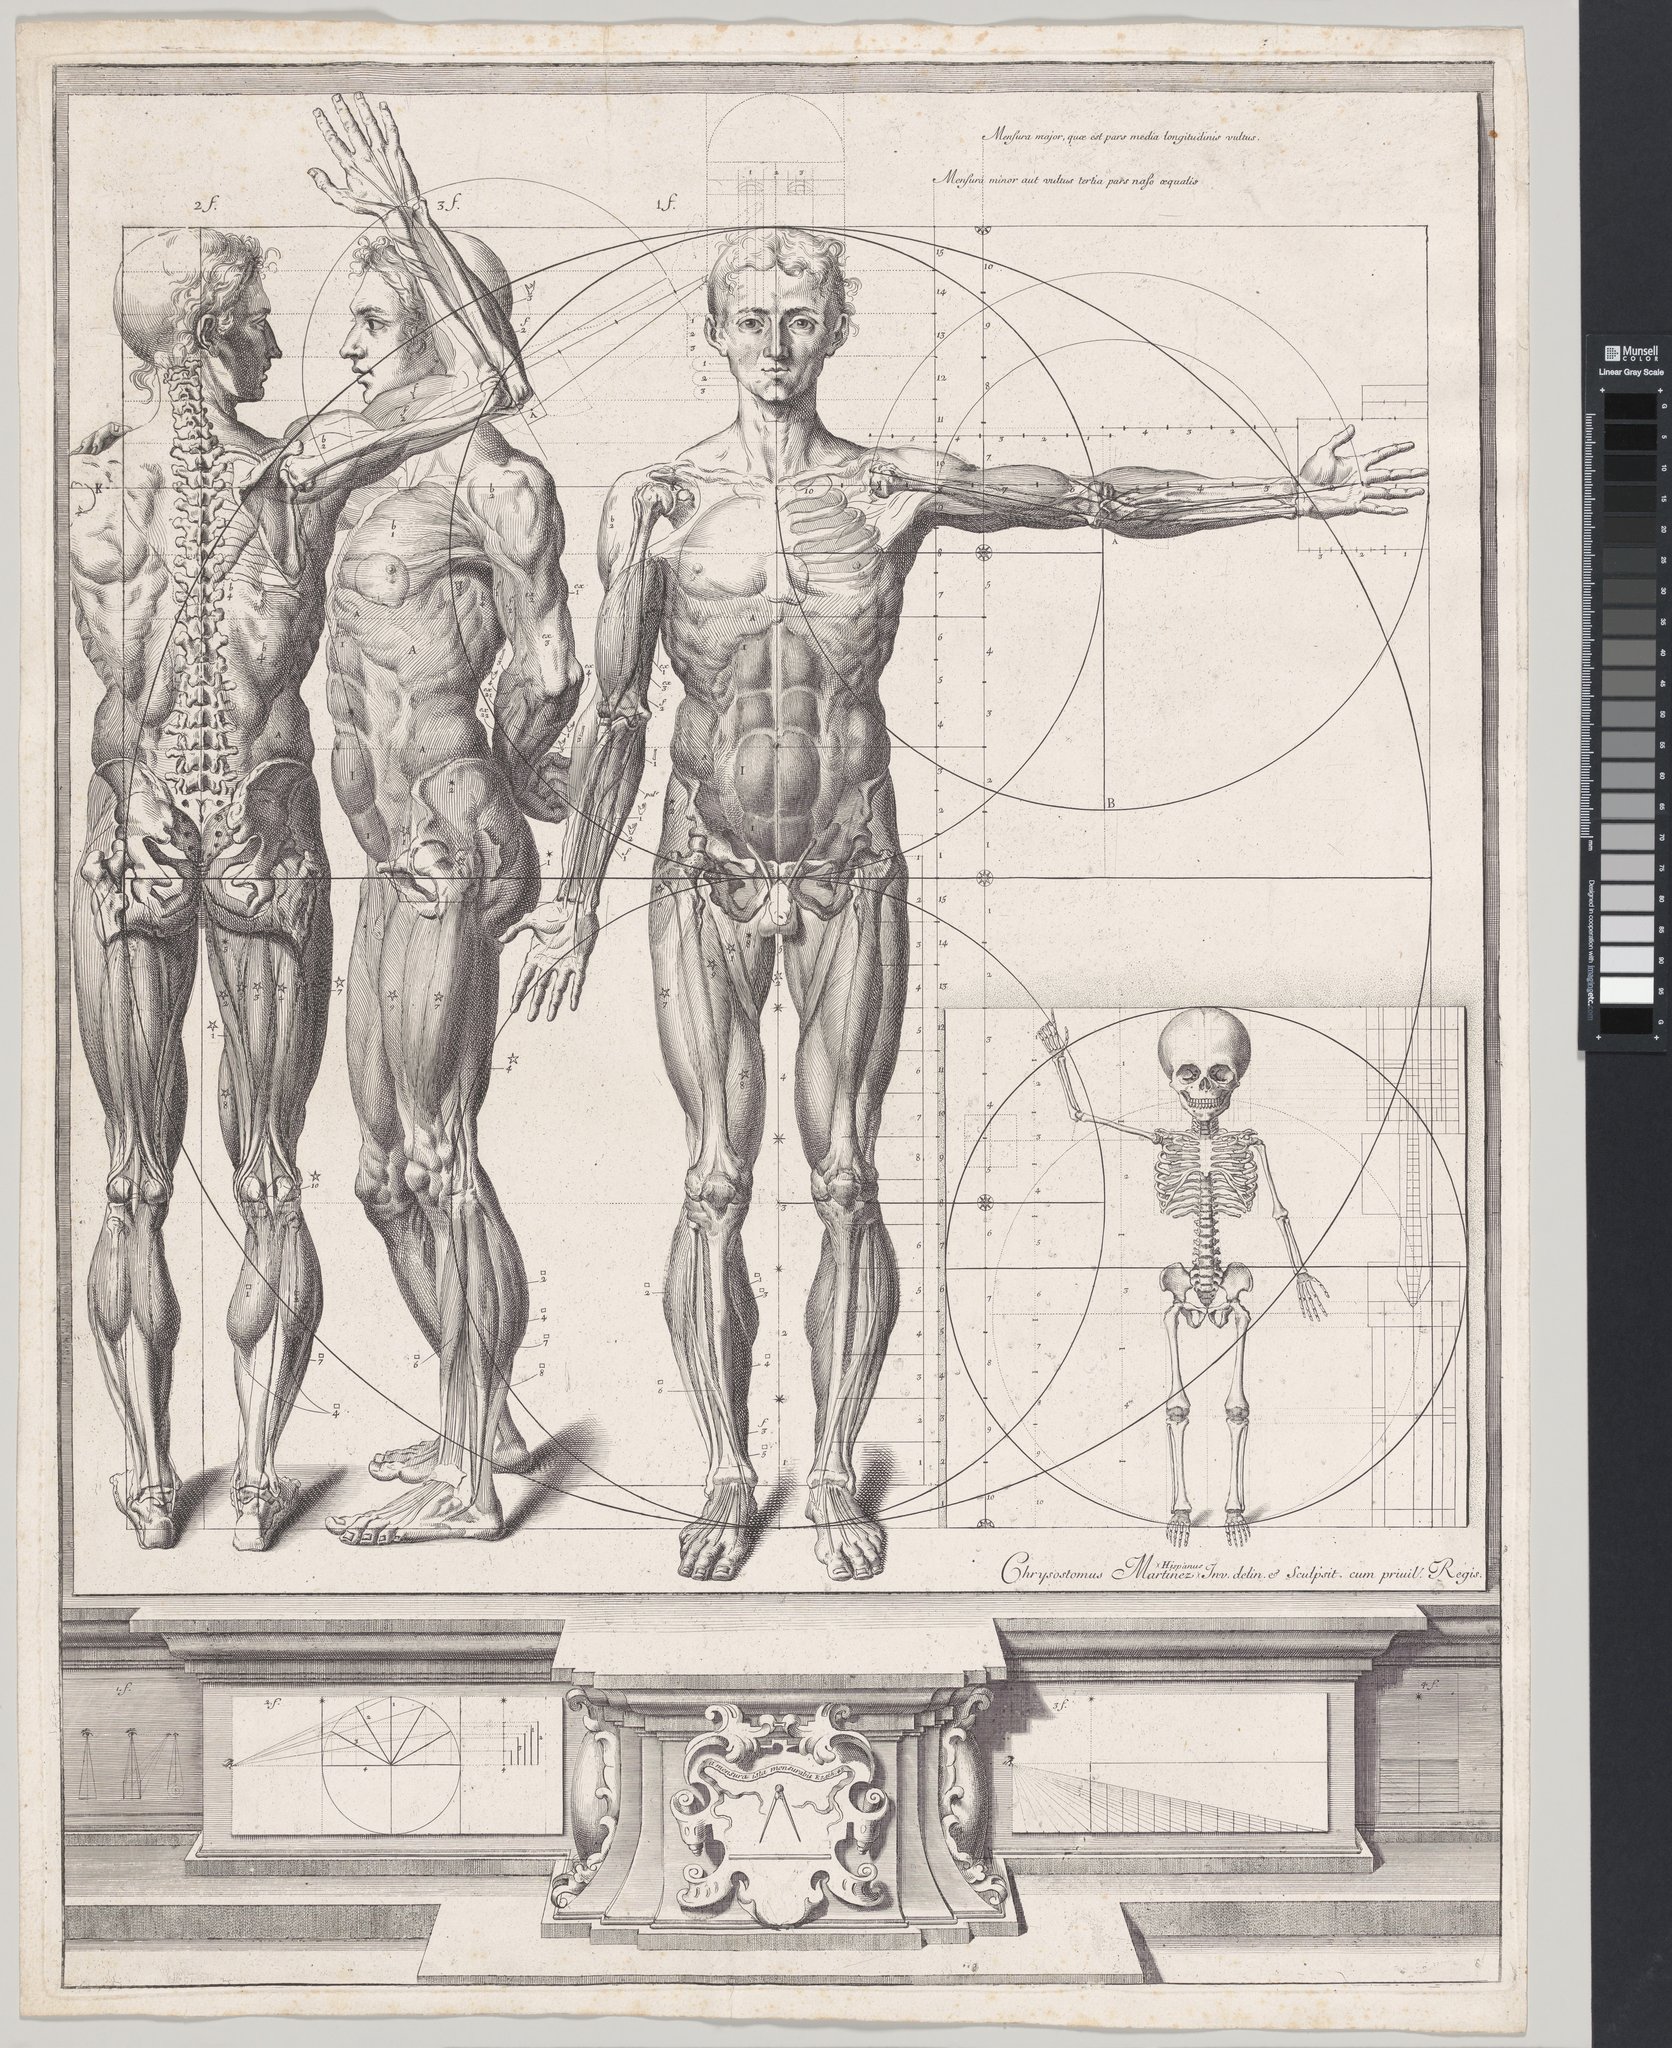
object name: print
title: Plate for the ‘Atlas Anatomico’ (unpublished)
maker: crisóstomo alejandrino josé martínez y sorli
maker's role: artist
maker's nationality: spanish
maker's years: 1638-1694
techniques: etching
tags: human anatomy,science,skeletons,men